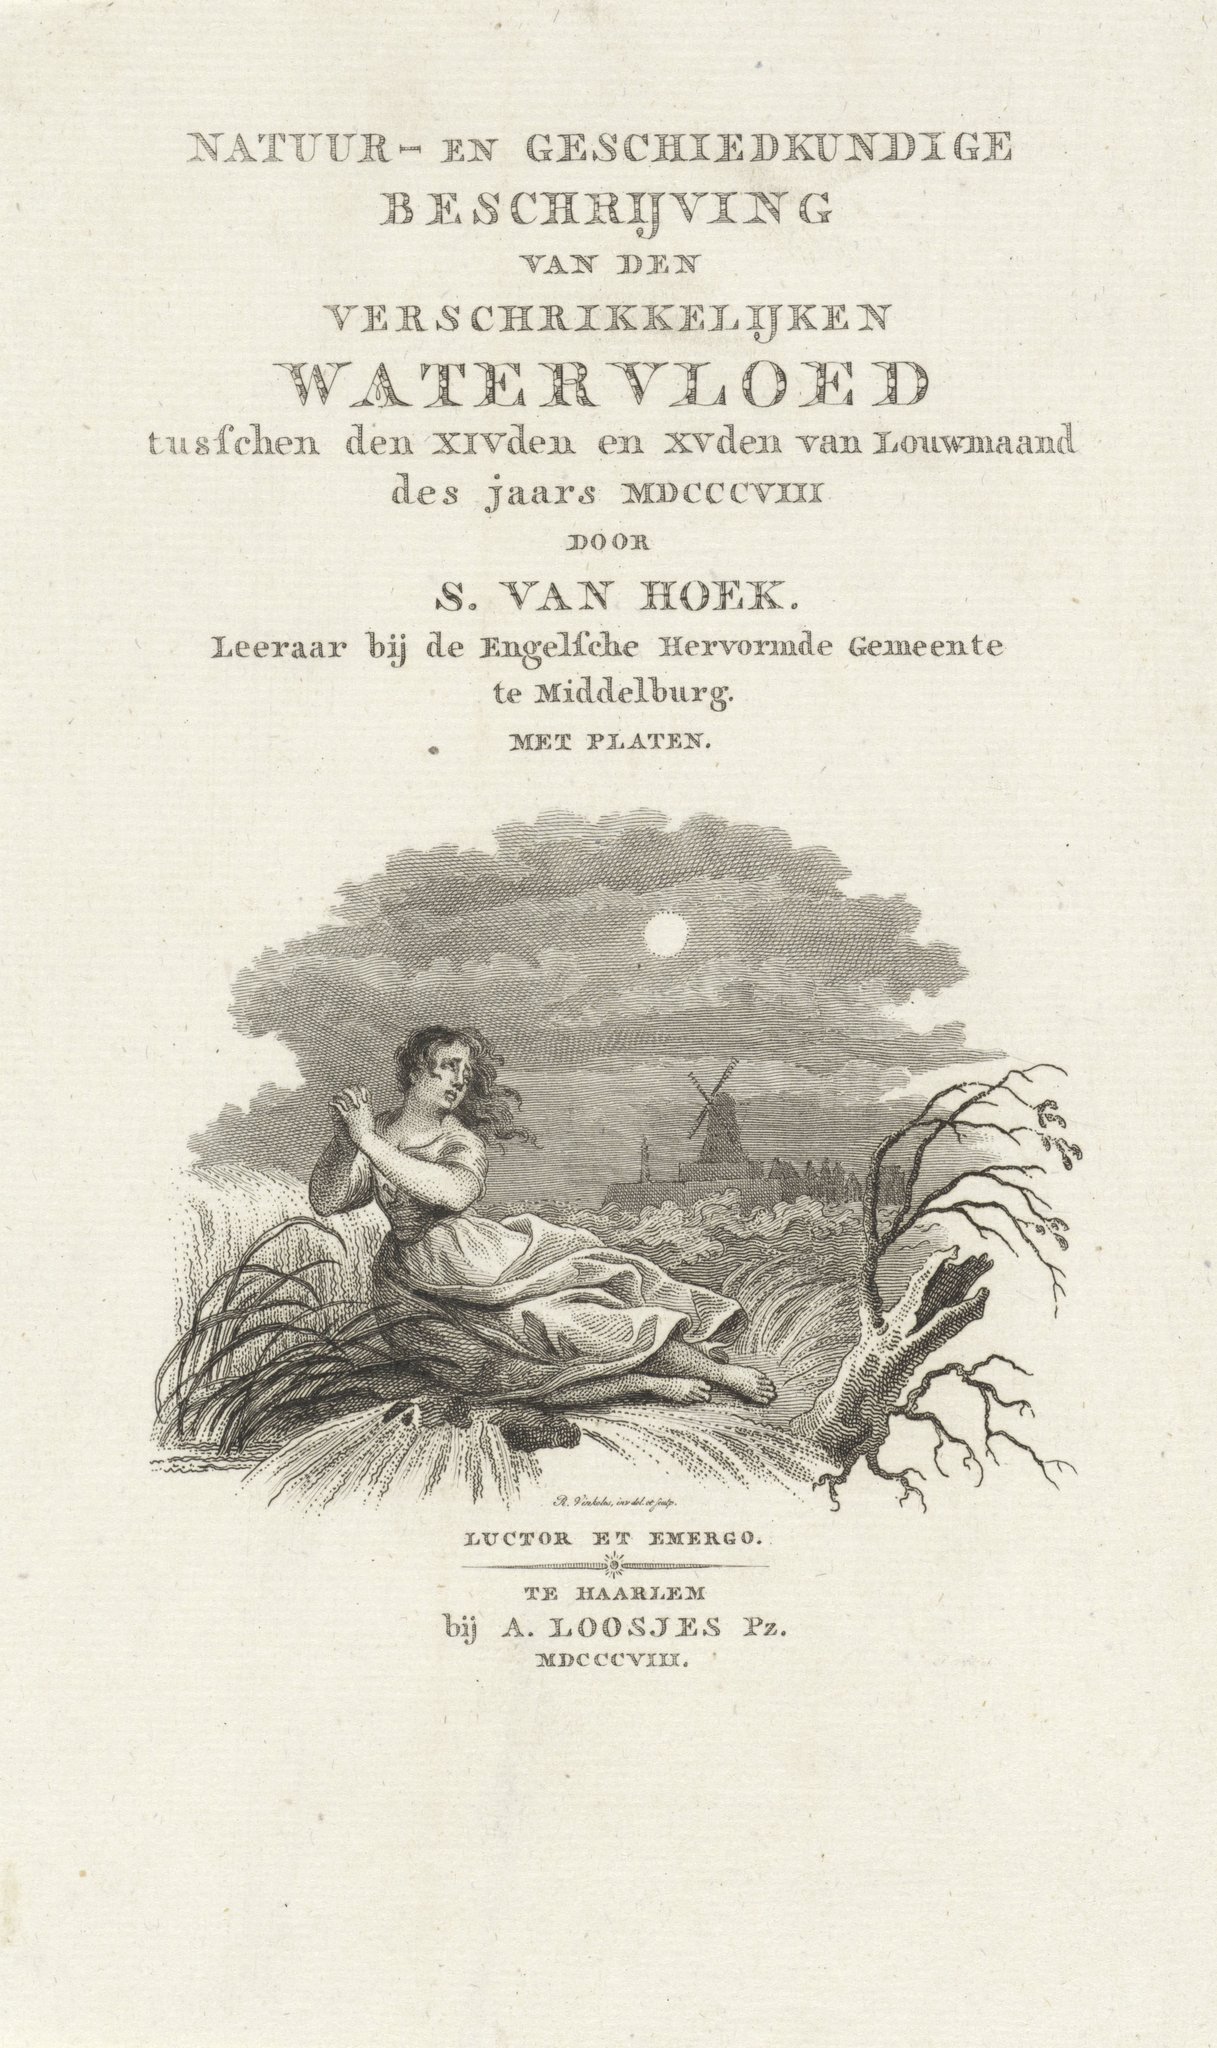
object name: titelblad, titelpagina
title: Titelpagina voor: S. van Hoek 'Natuur- en Geschiedkundige Beschrijving van den verschrikkelijken Watervloed', 1808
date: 1808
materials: paper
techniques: engraving, etching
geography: haarlem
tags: field filled with a crop (+ landscape with figures, staffage), flood, night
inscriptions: collector's mark: Lugt 2228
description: Titelpagina voor: Hoek, S. van. Natuur- en Geschiedkundige Beschrijving van den verschrikkelijken Watervloed. Haarlem: Adriaan Pietersz. Loosjes, 1808.